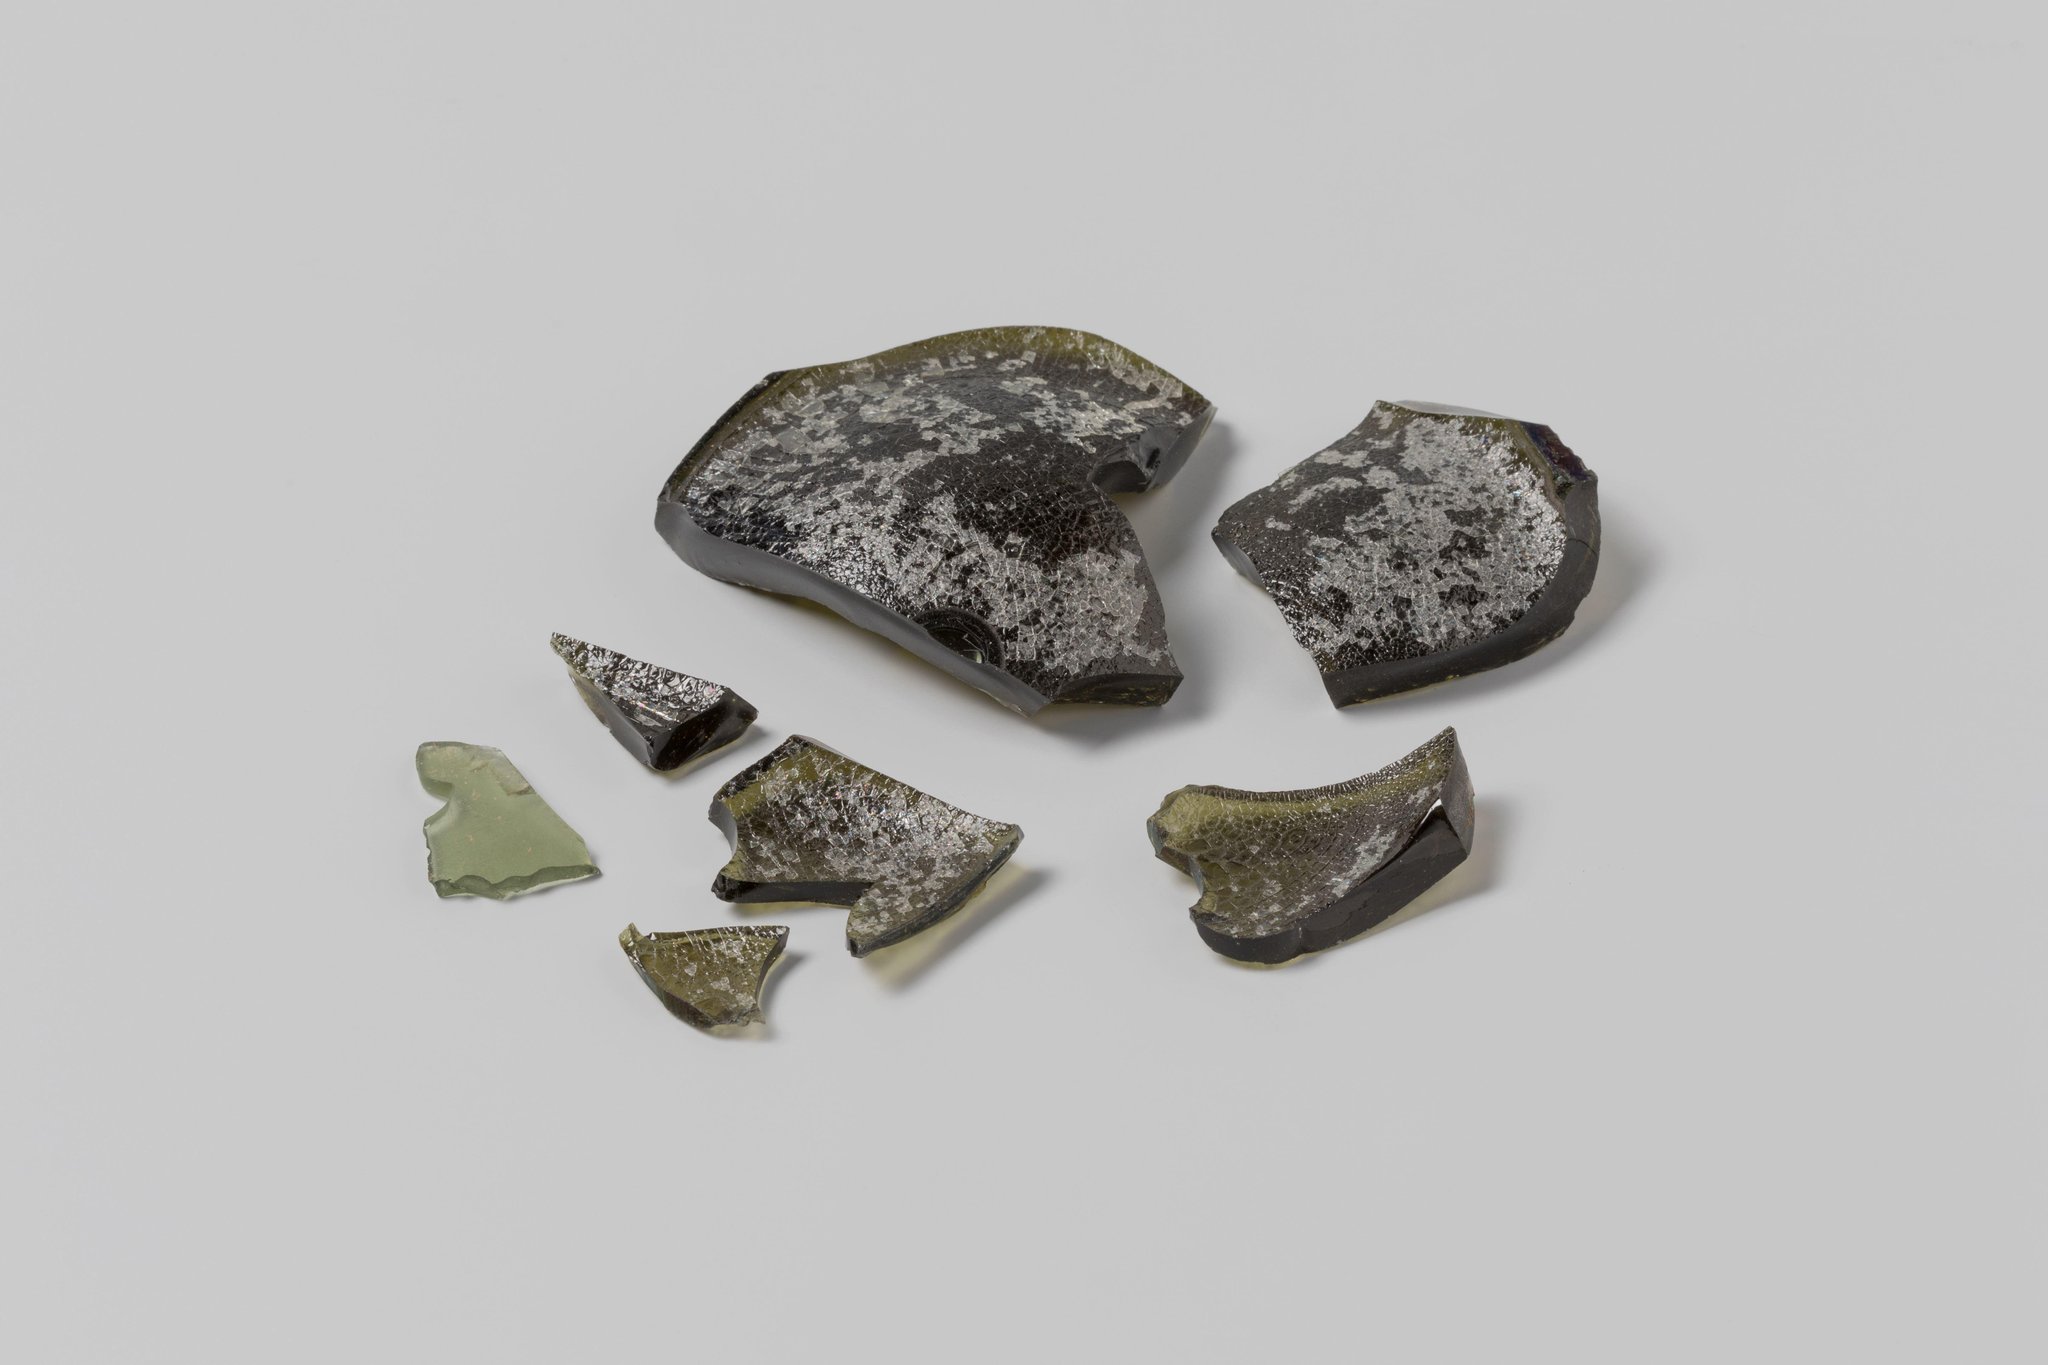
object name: sherd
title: Glasscherven van wijnflessen uit het wrak van de in 1735 vergane Oost-Indiëvaarder 't Vliegend Hart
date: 1700-1735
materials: glass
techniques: manufacturing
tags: 't vliegend hart (schip), verenigde oostindische compagnie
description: De zeven fragmenten maken deel uit van de bodems van wijnflessen, blijkens de dikkte van het groene glas en de opstaande wanden. Alle scherven hebben en gladde en een ruwe kant met aanslag en irizeren.